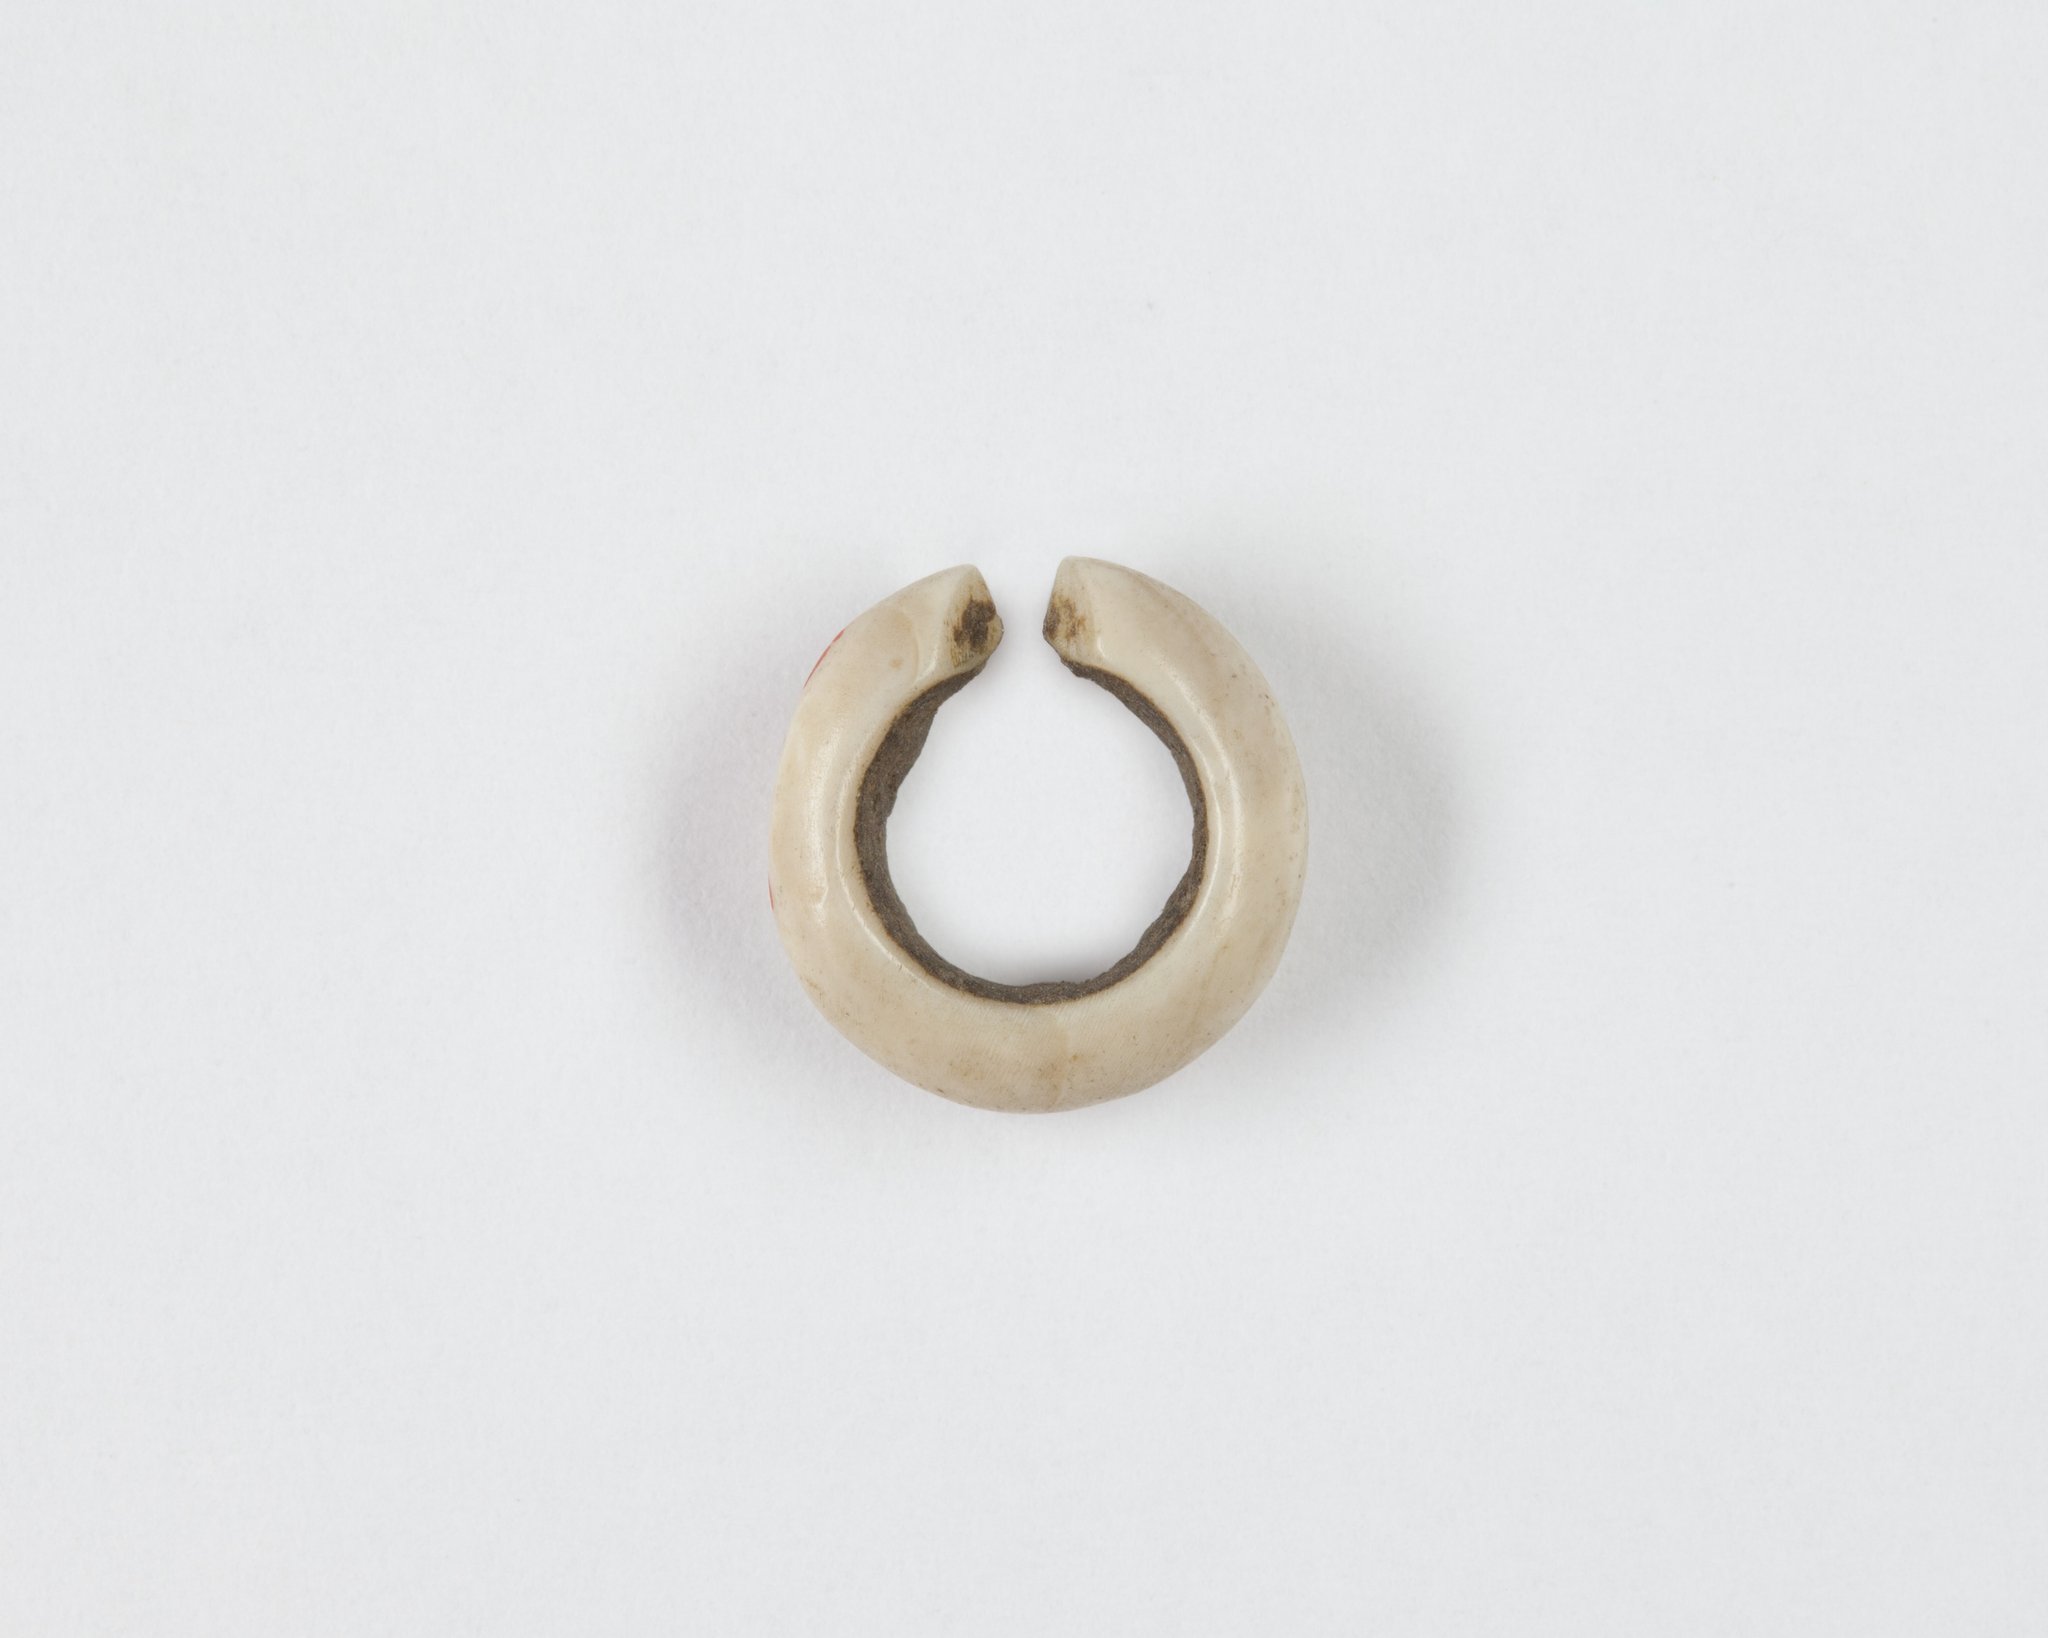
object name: earring, penannular, circular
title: Penannular Earring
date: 1550-1295 BCE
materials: shell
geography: northern upper egypt